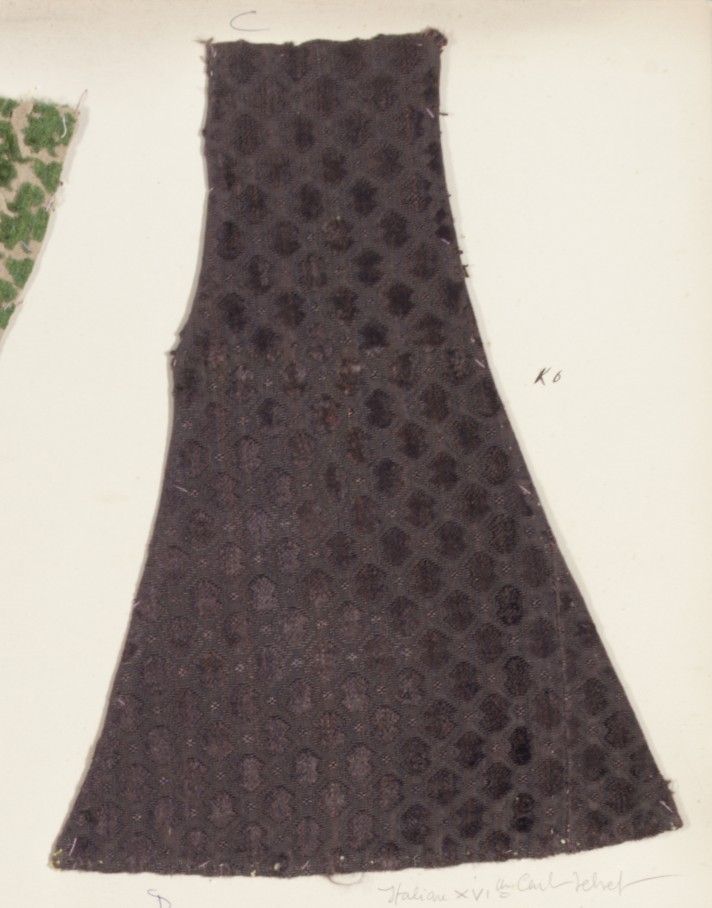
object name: fragment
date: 1501-1600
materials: silk